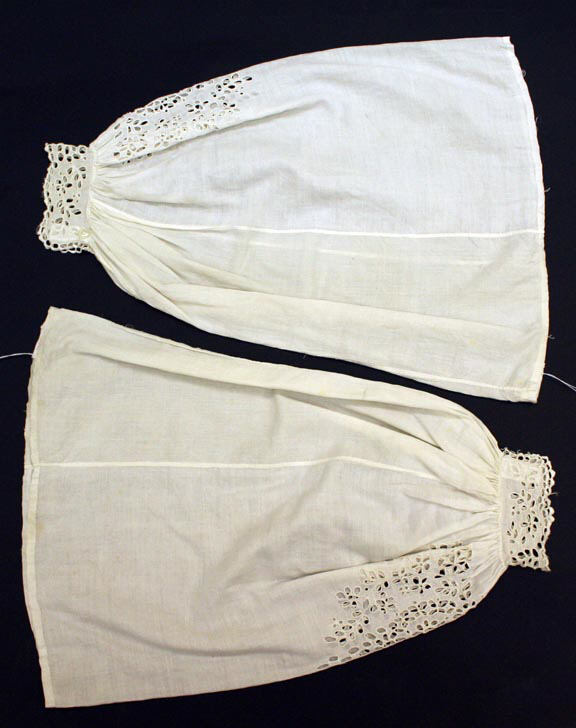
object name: undersleeves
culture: american or european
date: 1850-1859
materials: linen